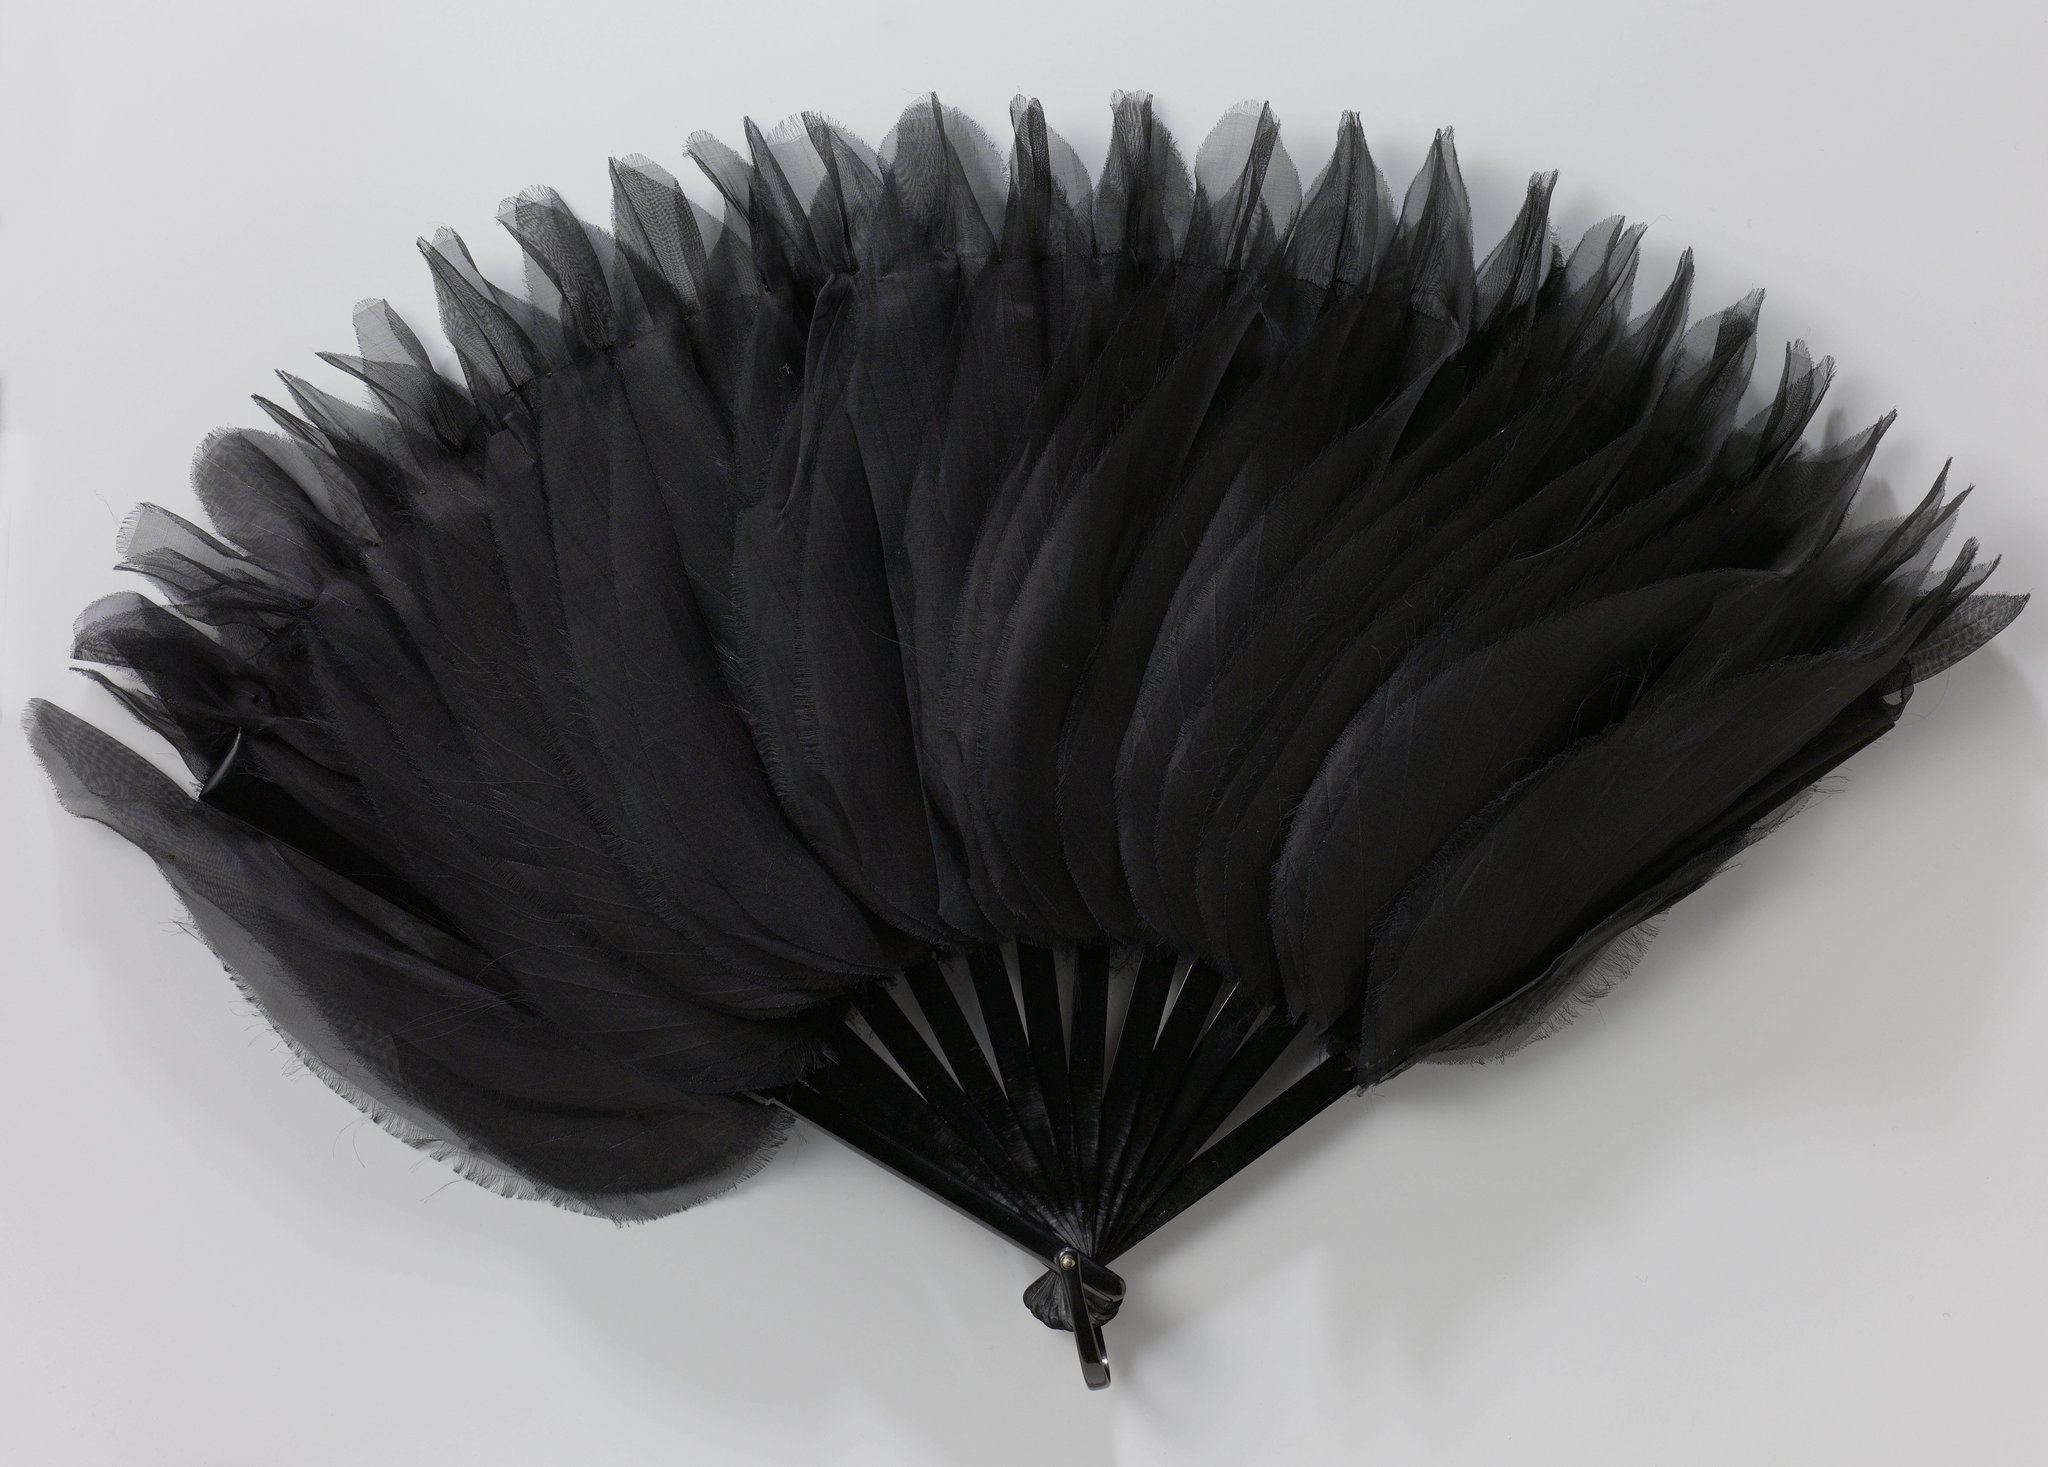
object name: vouwwaaier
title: Vouwwaaier van fijne zijden zwarte gaas waaraan zwarte stroken, op een zwart kunststof montuur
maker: coco chanel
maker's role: modeontwerper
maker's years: 1883-1971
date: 1920-1930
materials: copper, plastic, silk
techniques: cutting, sewing, weave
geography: paris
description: Vouwwaaier van fijne zijden zwarte gaas, waaraan zwarte stroken in de lengte zijn genaaid. De uiteinden hebben een puntige een vorm. De randen van de stof zijn gerafeld gelaten. Het montuur telt 14 niet aaneengesloten benen en is, net als de waaierring, van zwart kunststof vervaardigd.